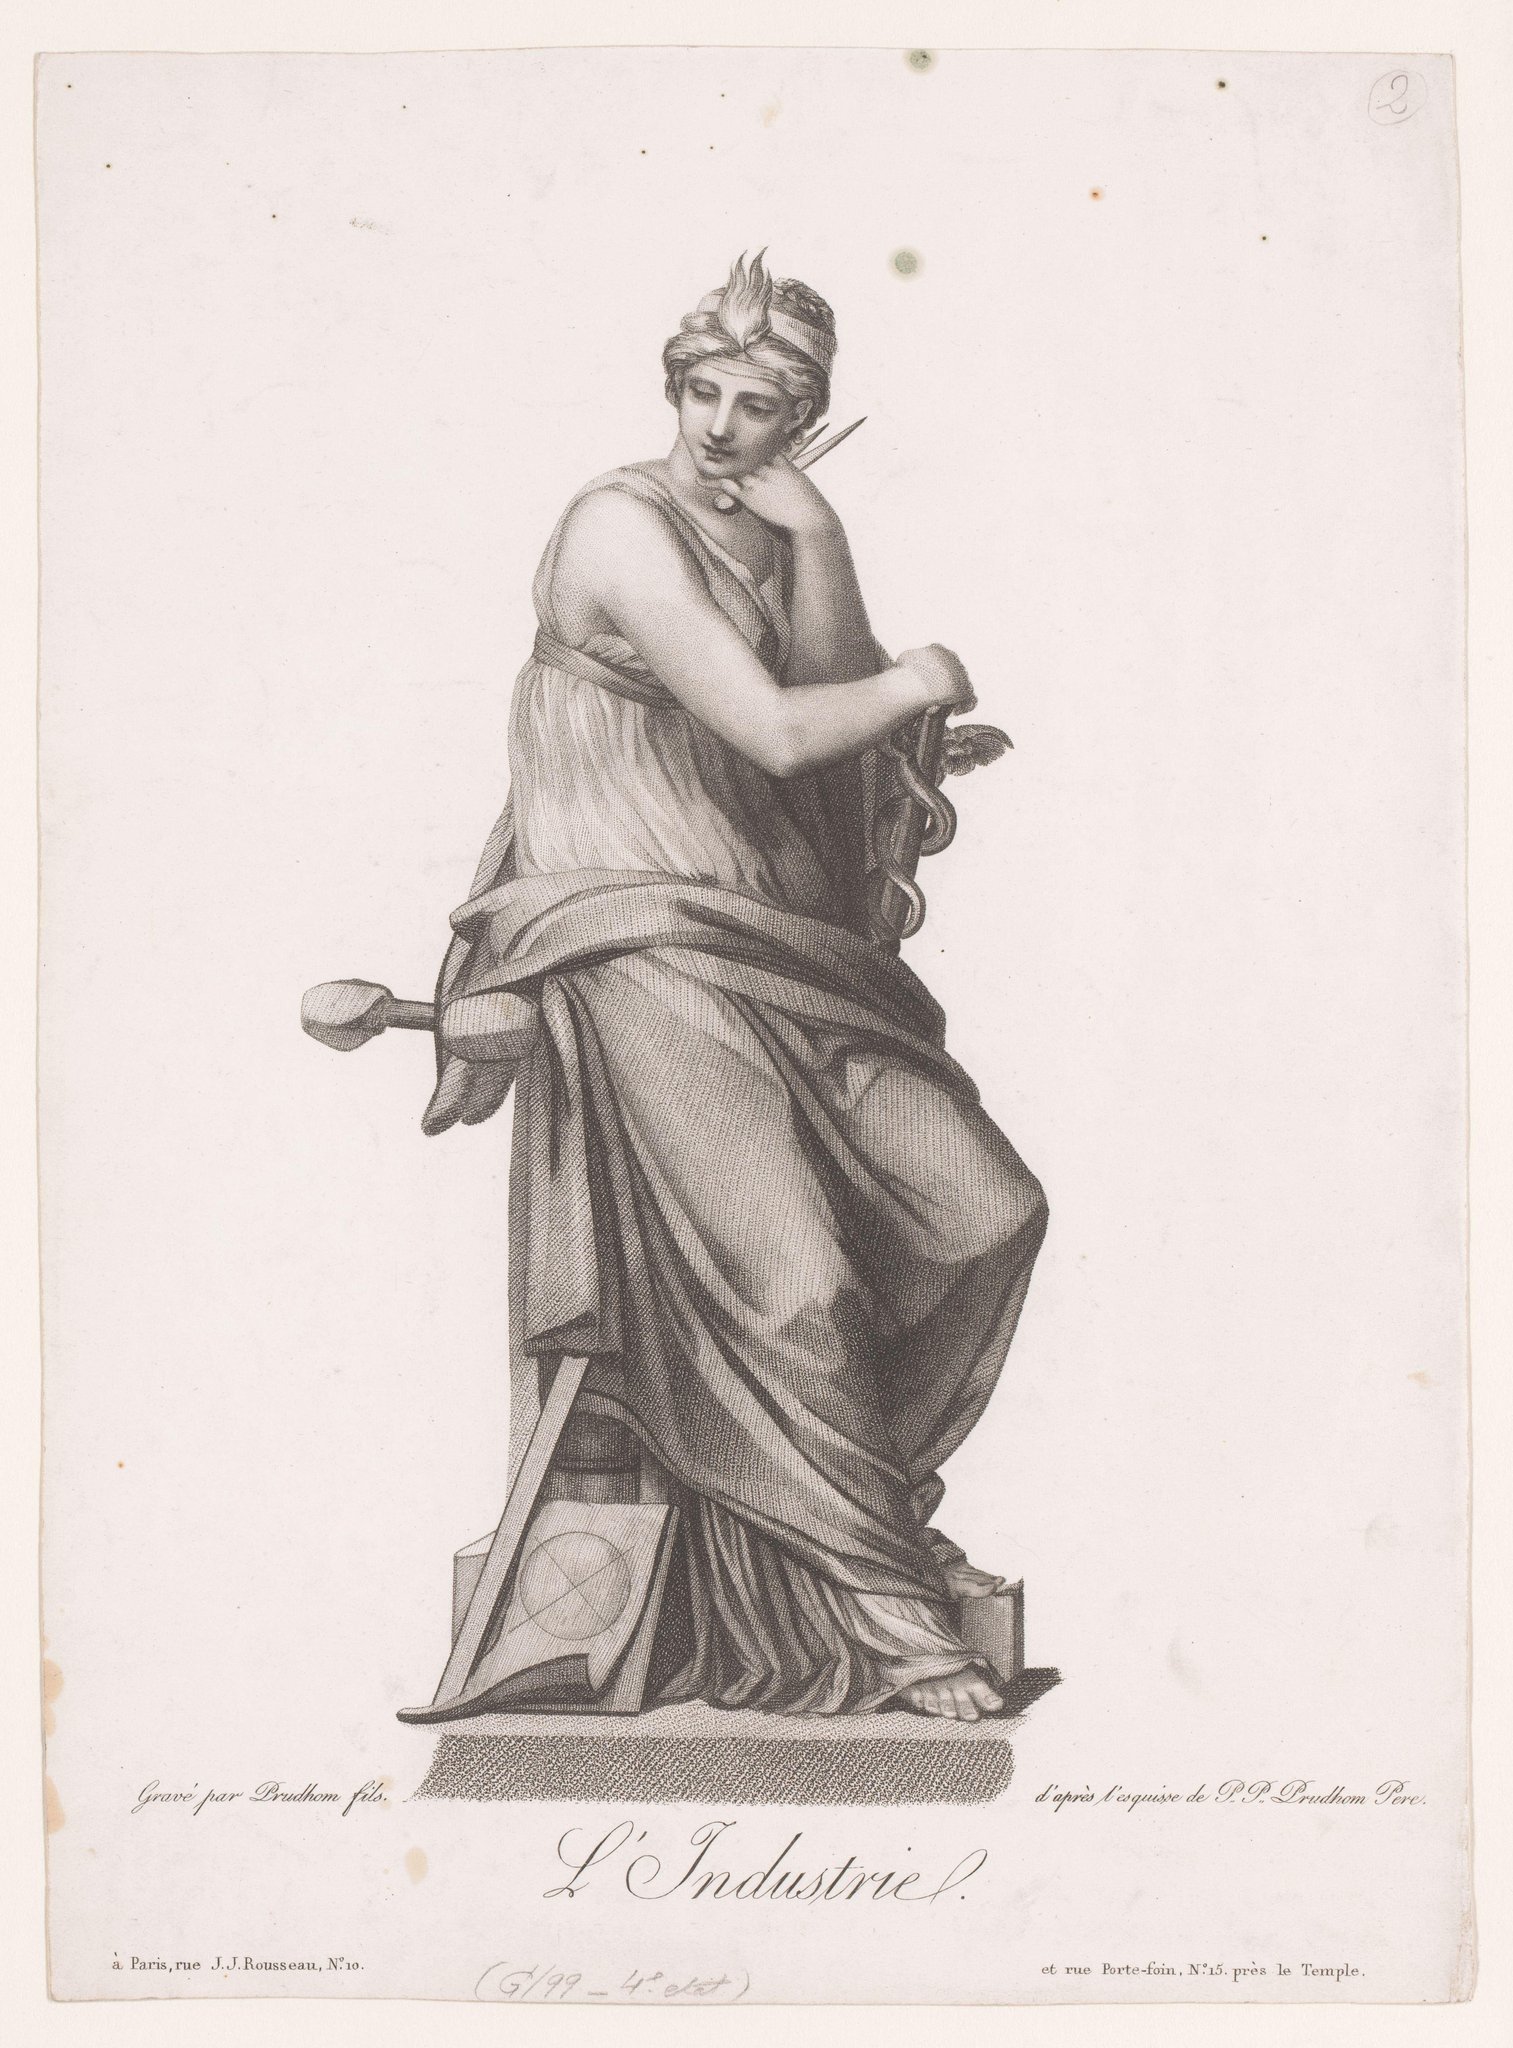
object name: print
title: L'Industrie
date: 1810-1823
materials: paper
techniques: engraving, etching, roulette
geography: paris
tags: industries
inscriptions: collector's mark: Lugt 2228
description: Serie naar de figuren die als decoratie gebruikt zijn in het stadhuis, tijdens het huwelijk van Napoleon I Bonaparte en Marie Louise van Oostenrijk in 1810.